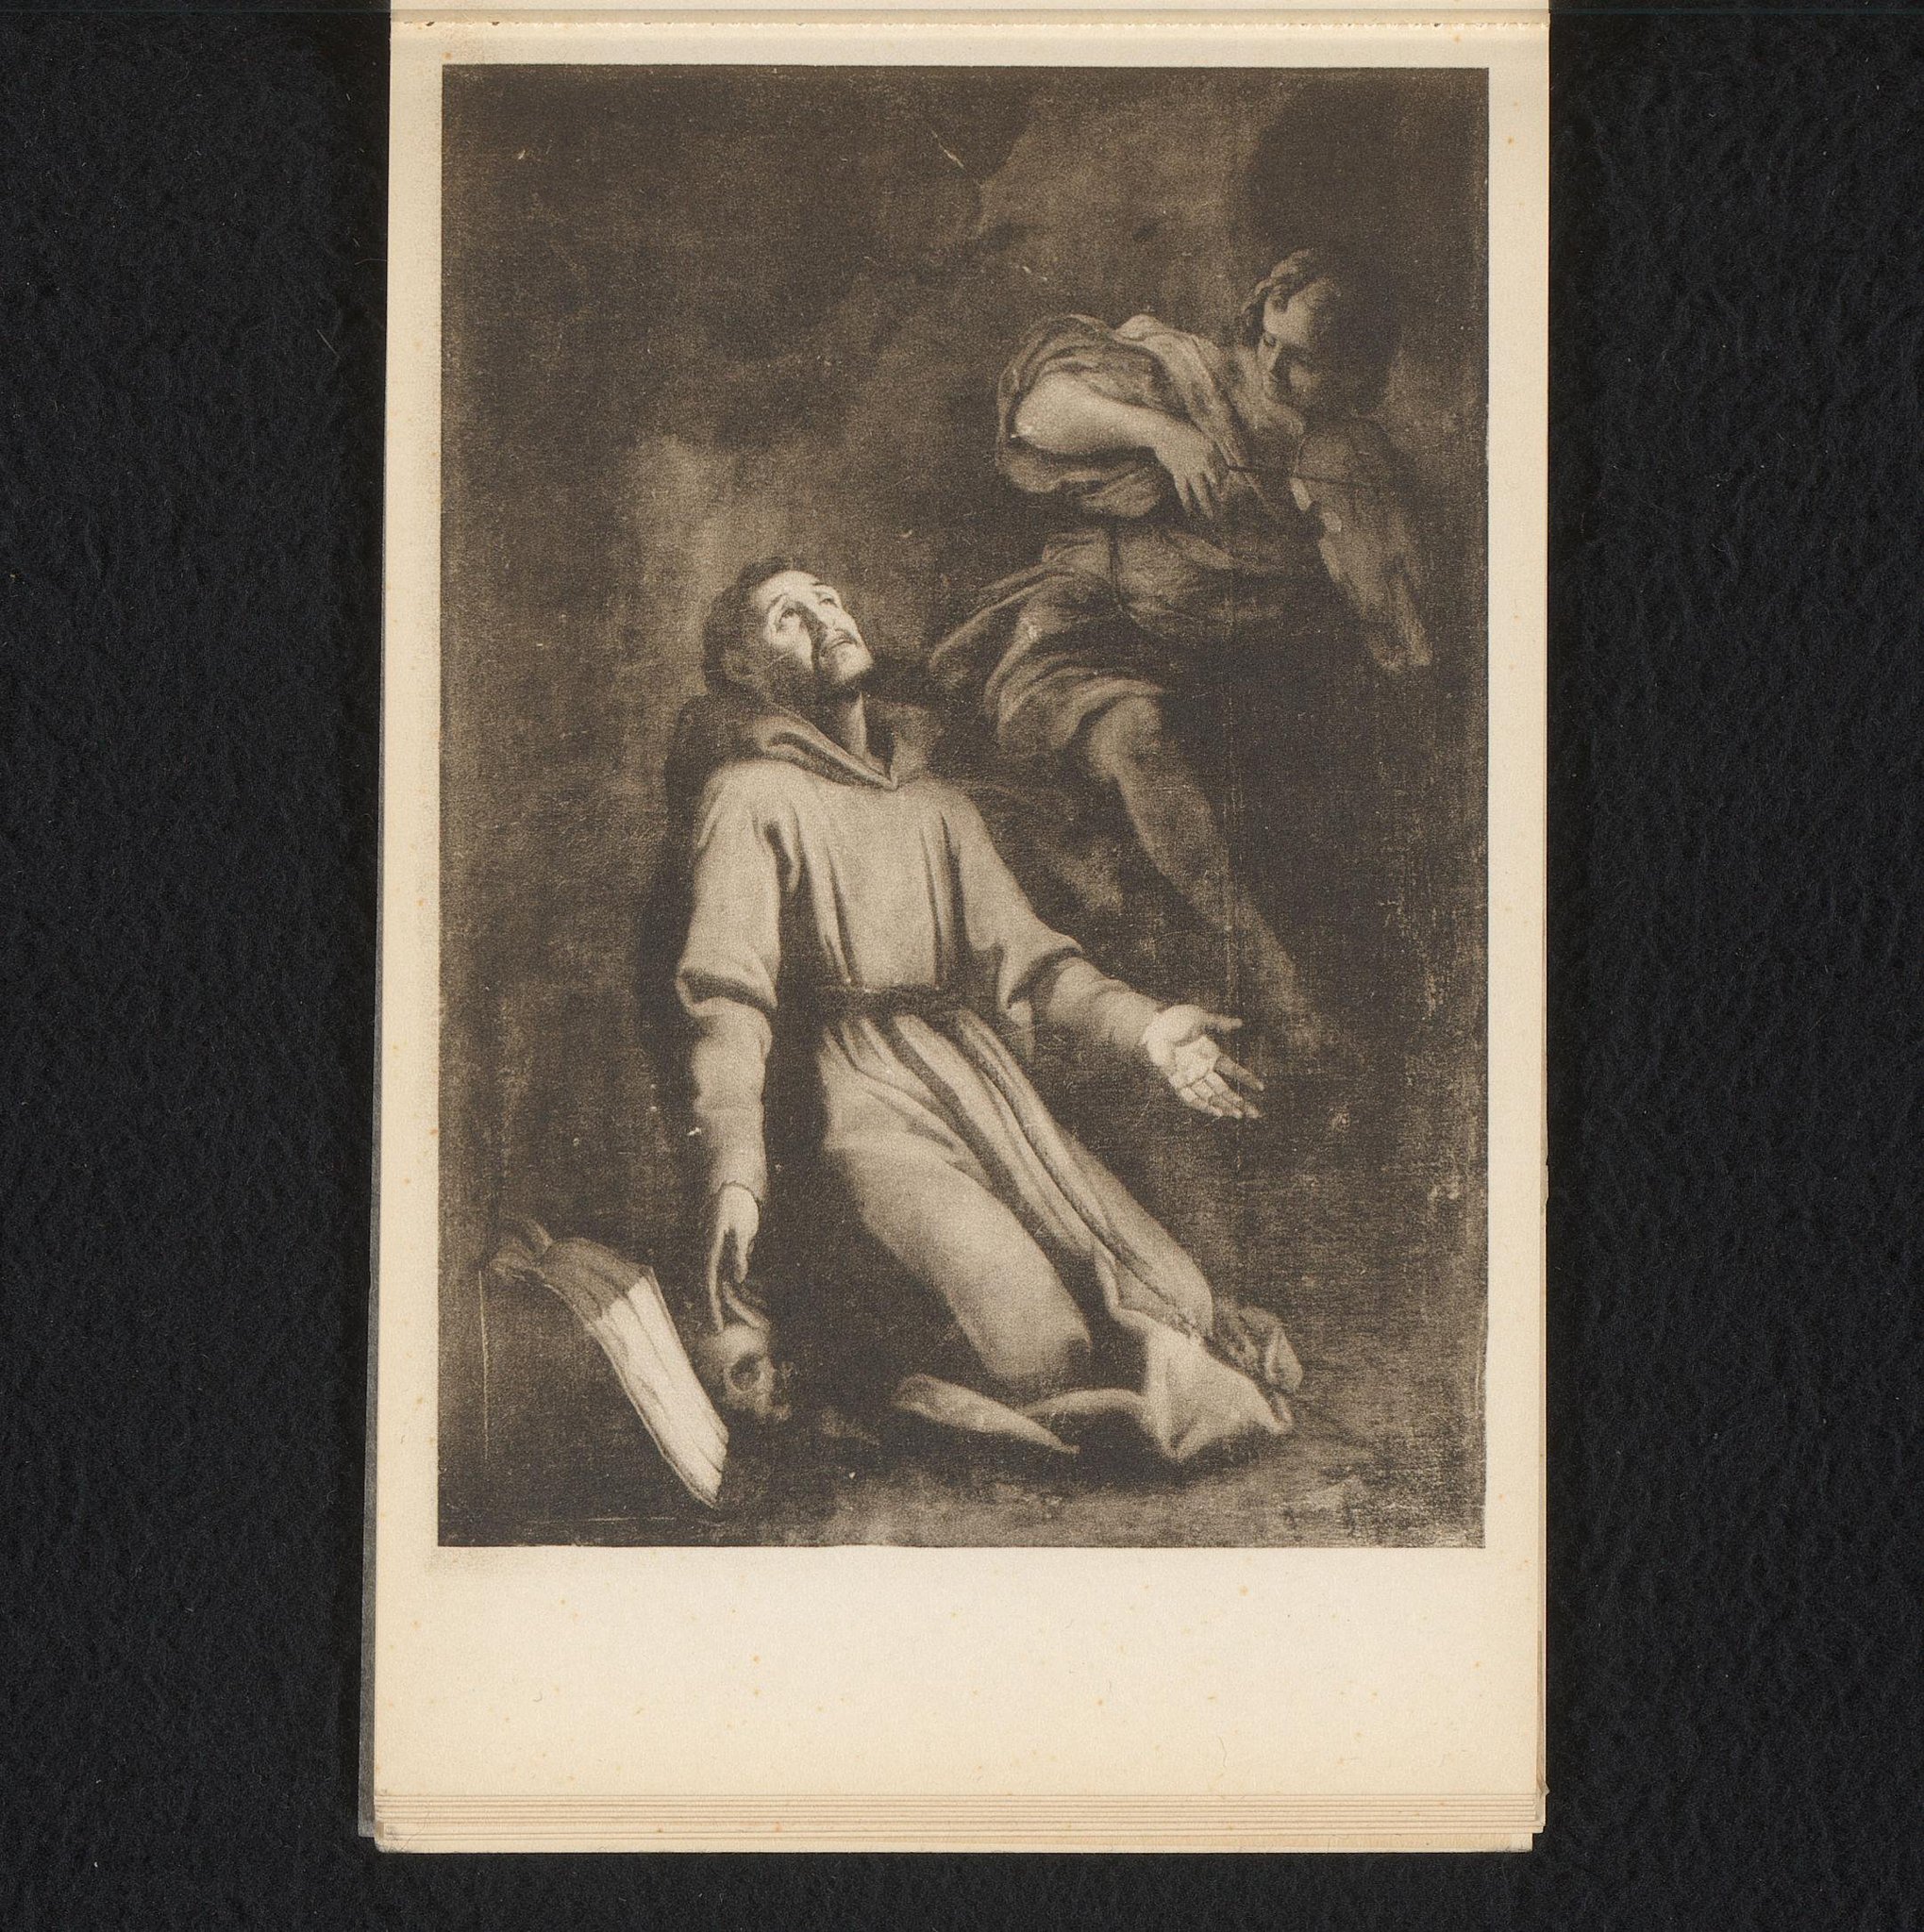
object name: ansichtkaart, prentbriefkaart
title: Museo Cerralbo. Madrid. San Francisco en éxtasis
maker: lucas piti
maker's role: painter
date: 1924-1930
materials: cardboard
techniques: photograph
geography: madrid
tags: permanent exhibition, museum, picture, painting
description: Prentbriefkaart maakt deel uit van een album.